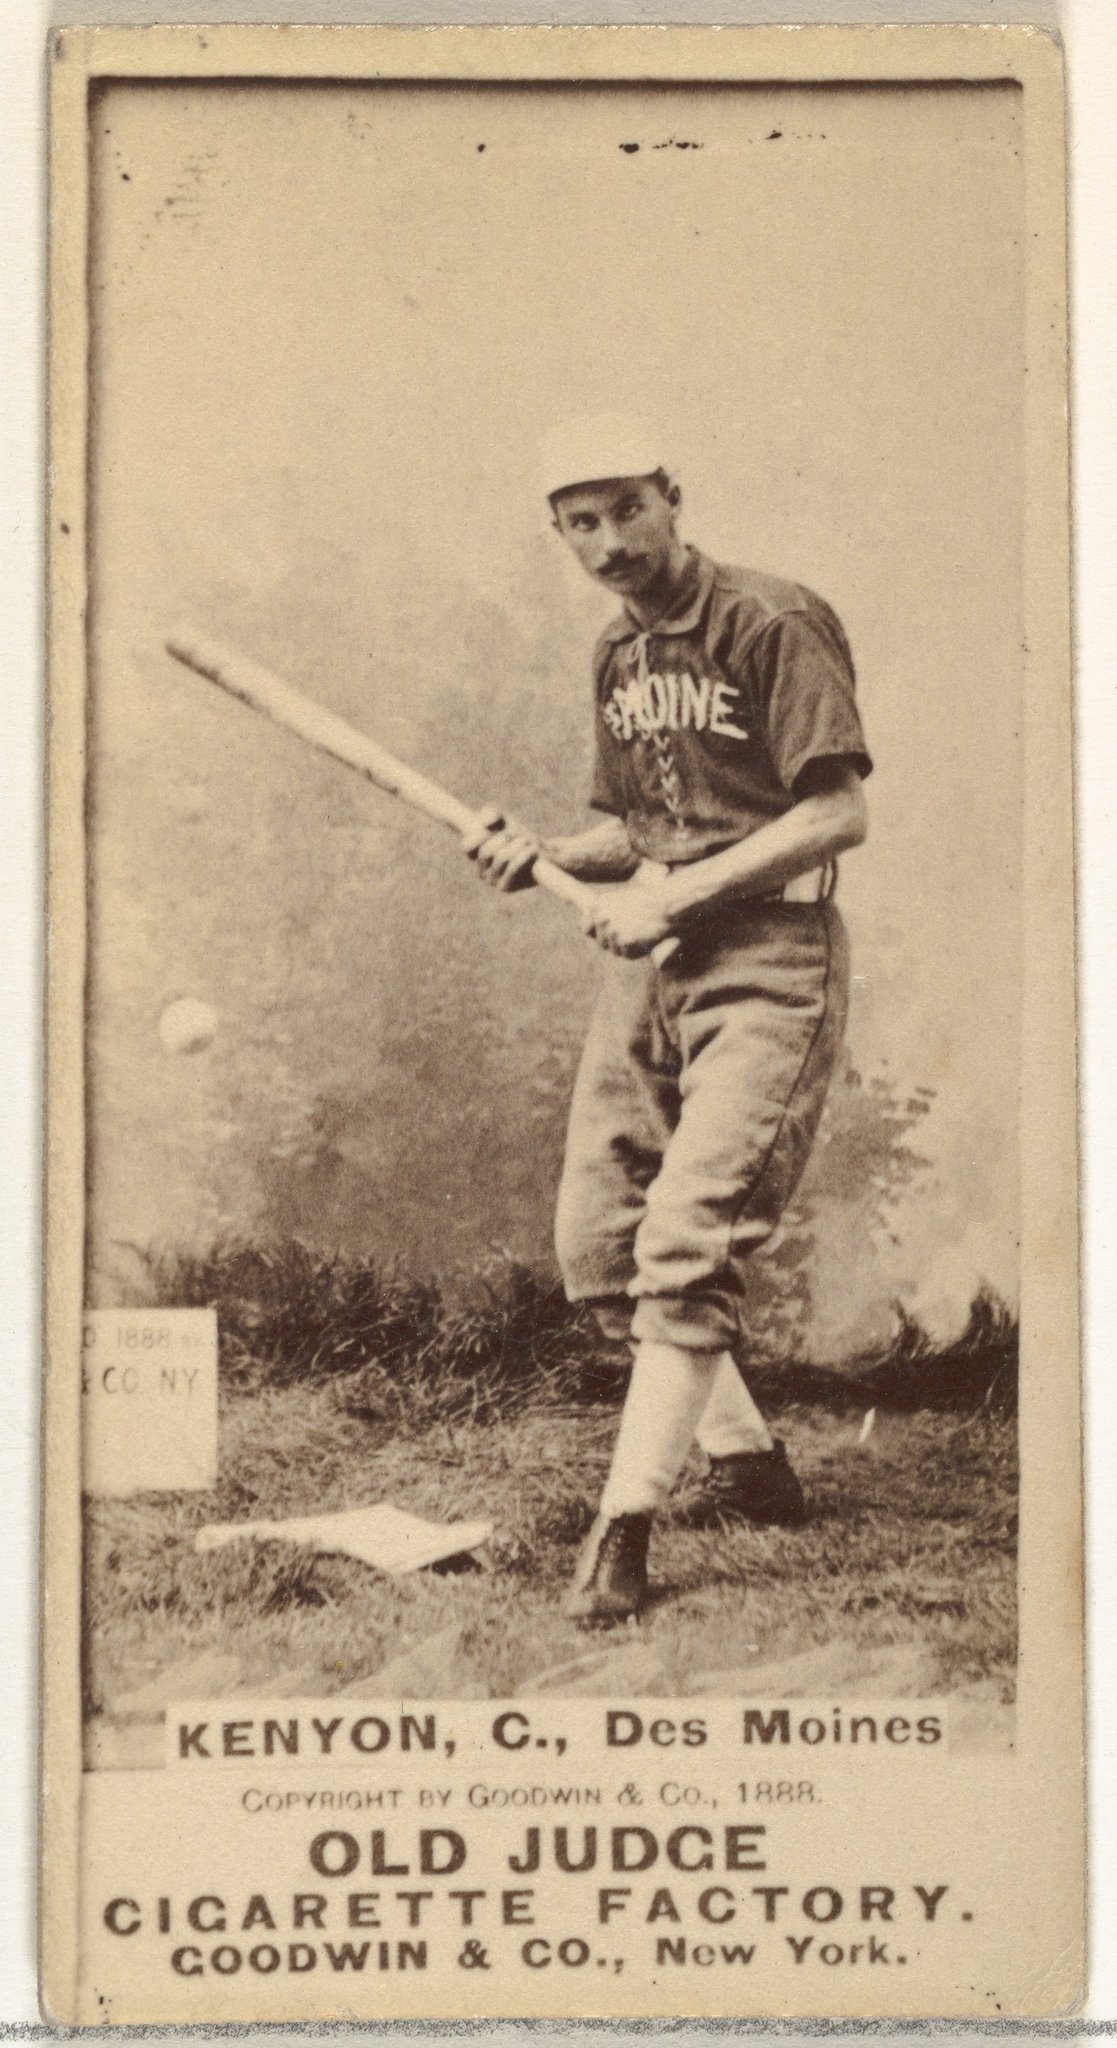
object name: baseball card, photograph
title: P. Jacob "Jack" Kenyon, Catcher, Des Moines Prohibitionists, from the Old Judge series (N172) for Old Judge Cigarettes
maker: goodwin & company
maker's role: publisher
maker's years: 1850-1950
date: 1888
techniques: albumen silver print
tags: men,portraits,baseball,athletes